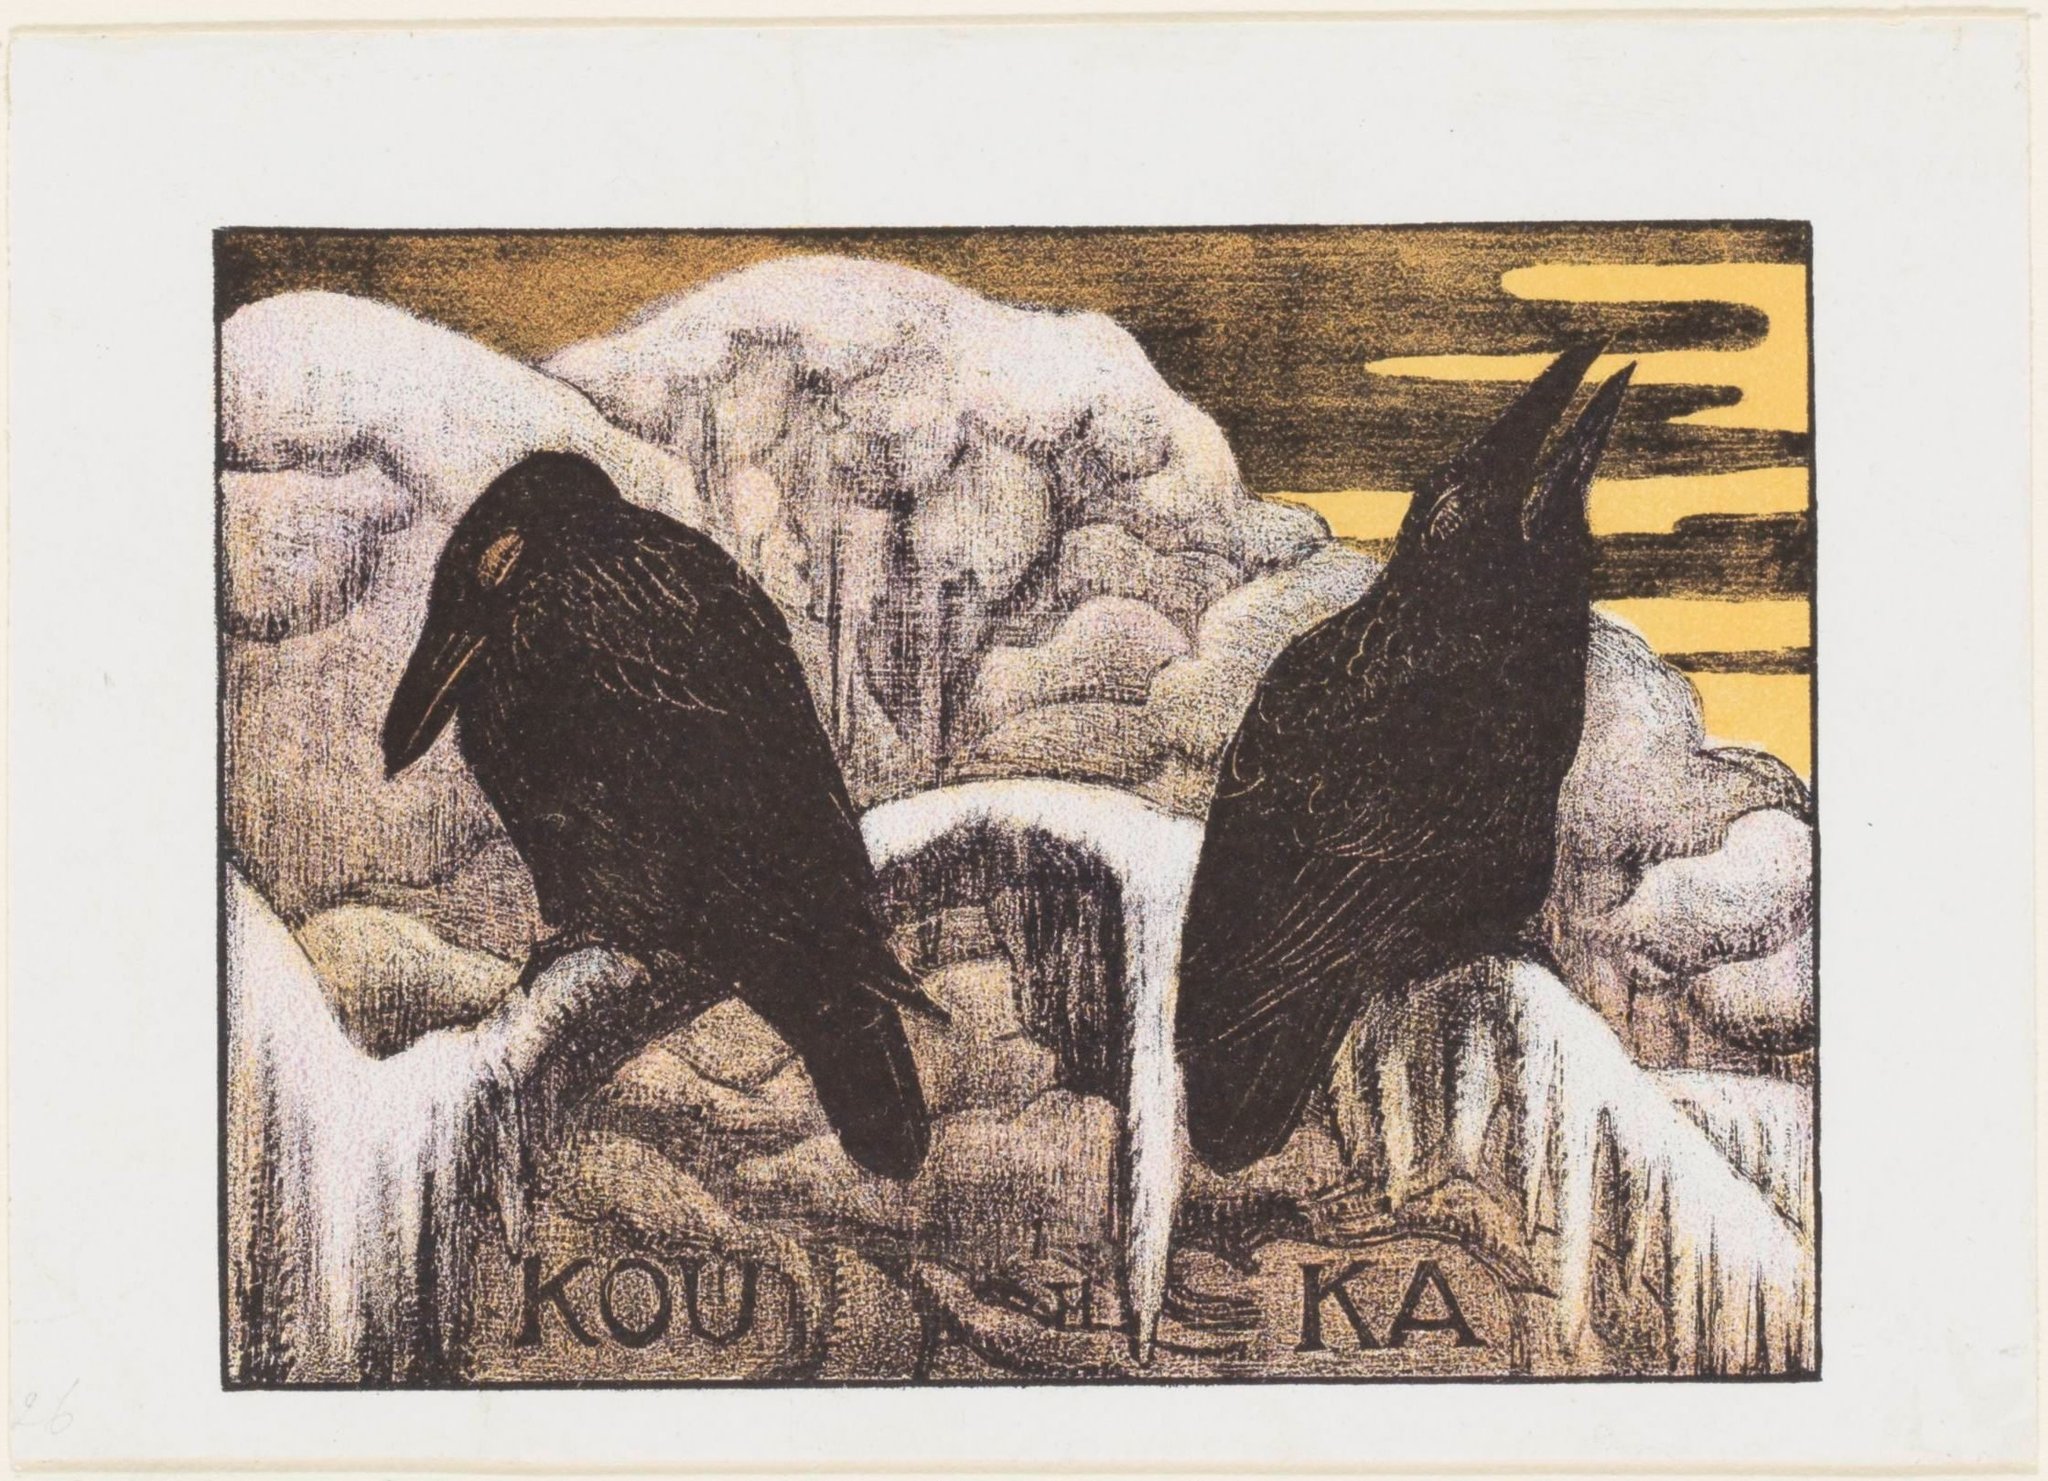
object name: print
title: Omslag zakkalender voor Van Houten Cacao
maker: theo van hoytema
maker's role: draughtsman, painter, print maker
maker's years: 1863-1917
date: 1903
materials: paper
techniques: lithograph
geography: weesp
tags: song-birds: jackdaw, song-birds: crow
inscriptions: : ‘Th. v Houten & Co Weesp’, collector's mark: Lugt 2233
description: Een kraai en een kauw op een besneeuwde tak. Links het woord 'kou', rechts het woord 'ka'.